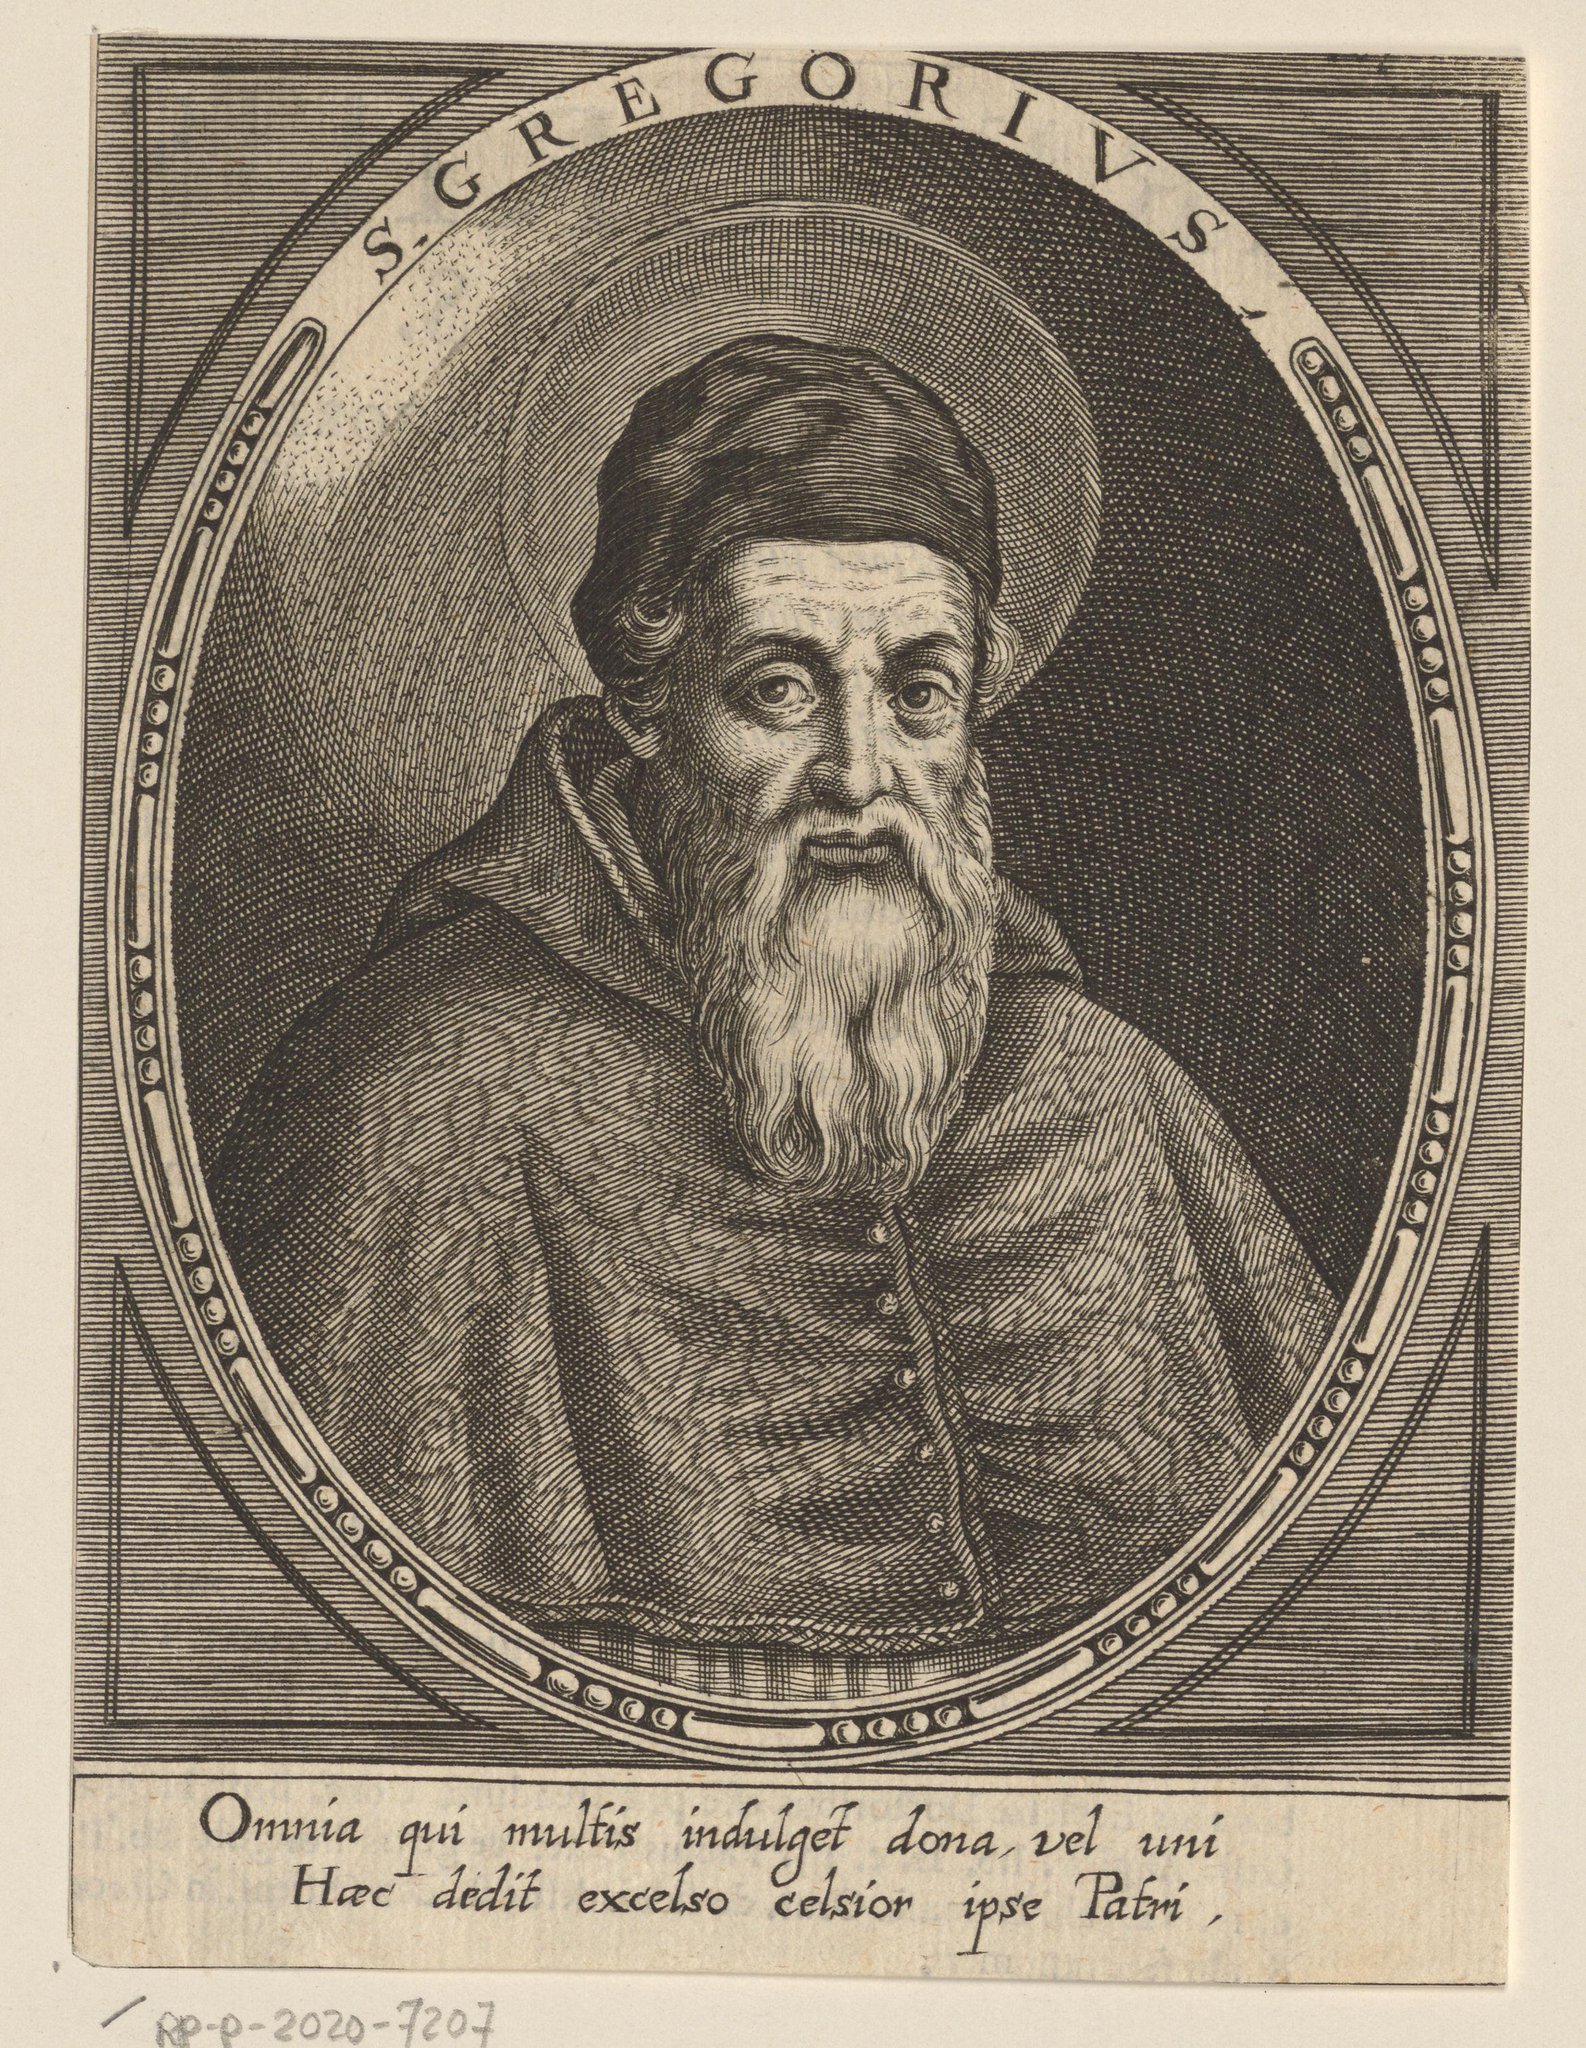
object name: print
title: Portret van paus Gregorius I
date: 1671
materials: paper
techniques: engraving, letterpress printing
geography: augsburg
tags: historical persons, pope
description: Prent uit: Spitzel, Gottlieb. Vetus academia Jesu Christi, in qua XXII priscae sincerae (...). Augsburg: Gottlieb Göbel, 1671, [dl. 79-110], p. 187.